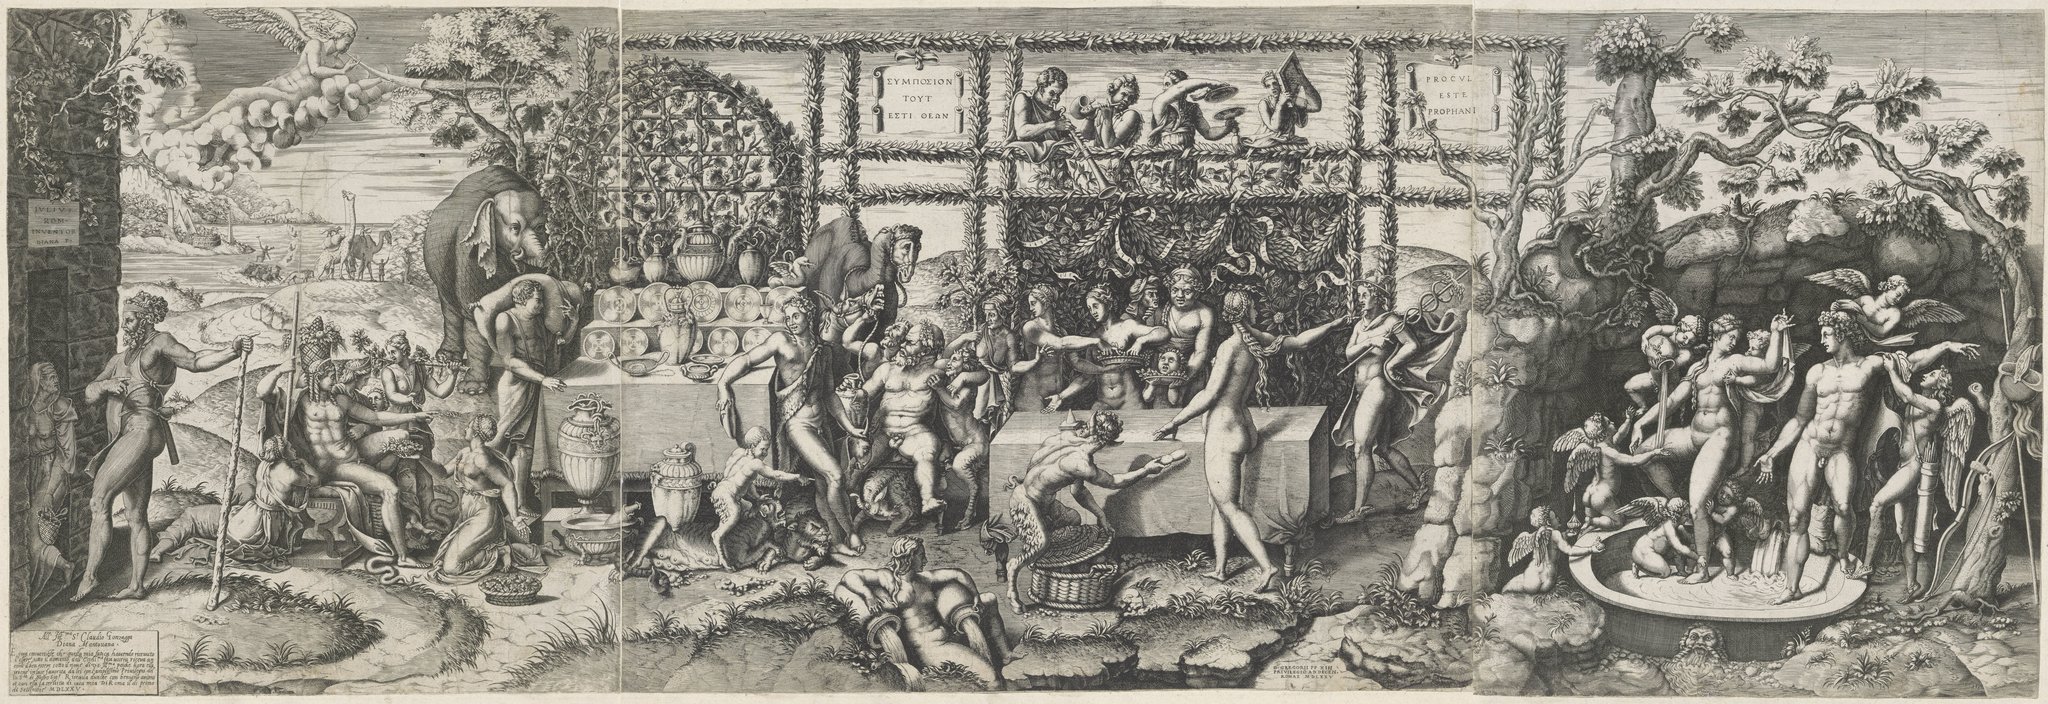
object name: print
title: Wedding Feast of Cupid and Psyche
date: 1575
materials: paper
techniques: engraving, etching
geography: rome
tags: marriage of cupid and psyche, beasts of prey, predatory animals: lion, trunked animals: elephant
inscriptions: collector's mark: Lugt 240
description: Diana Mantuana made her Rome debut with this spectacular print. She based it on a fresco by Giulio Romano in her native Mantua. By dedicating the ambitious engraving to the Mantuan nobleman Claudio Gonzaga, she associated herself with this important patron and senior figure at the papal court in Rome. A strategic move, as in this way Mantuana’s work gained authority.